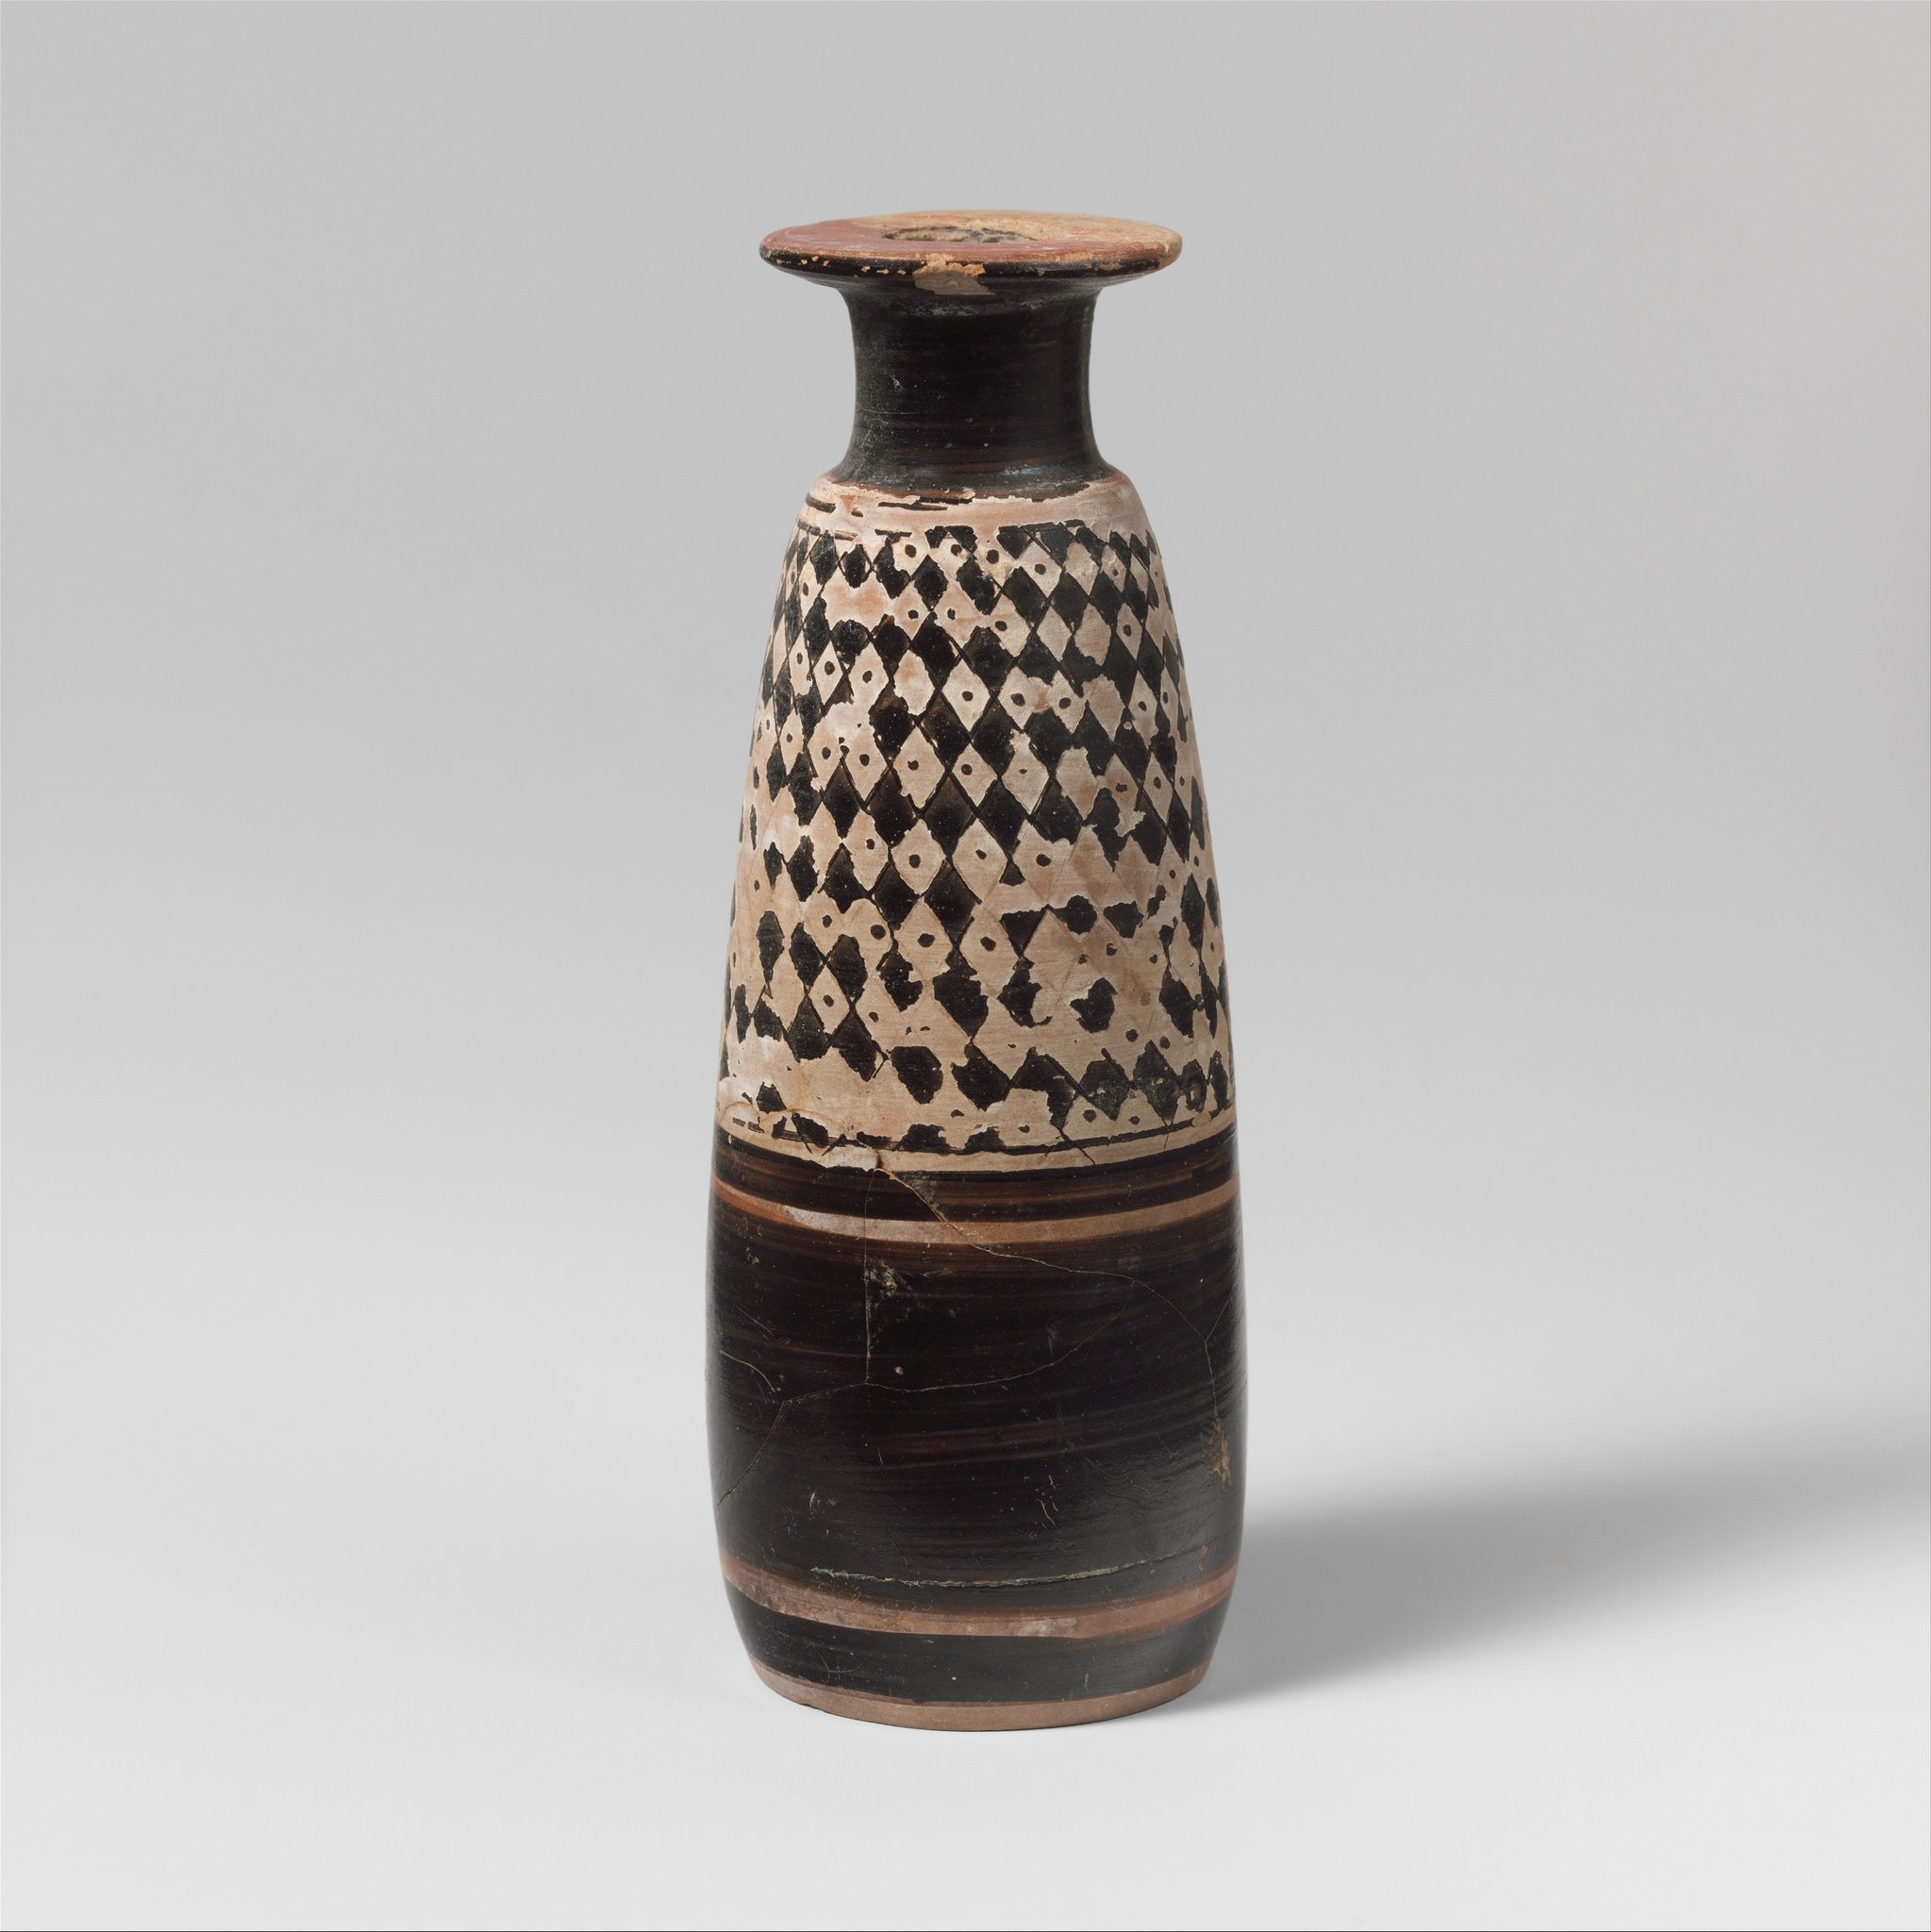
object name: alabastron, columbus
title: Terracotta Columbus alabastron (perfume vase)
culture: greek, attic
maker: beldam painter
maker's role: artist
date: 470 BCE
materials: terracotta